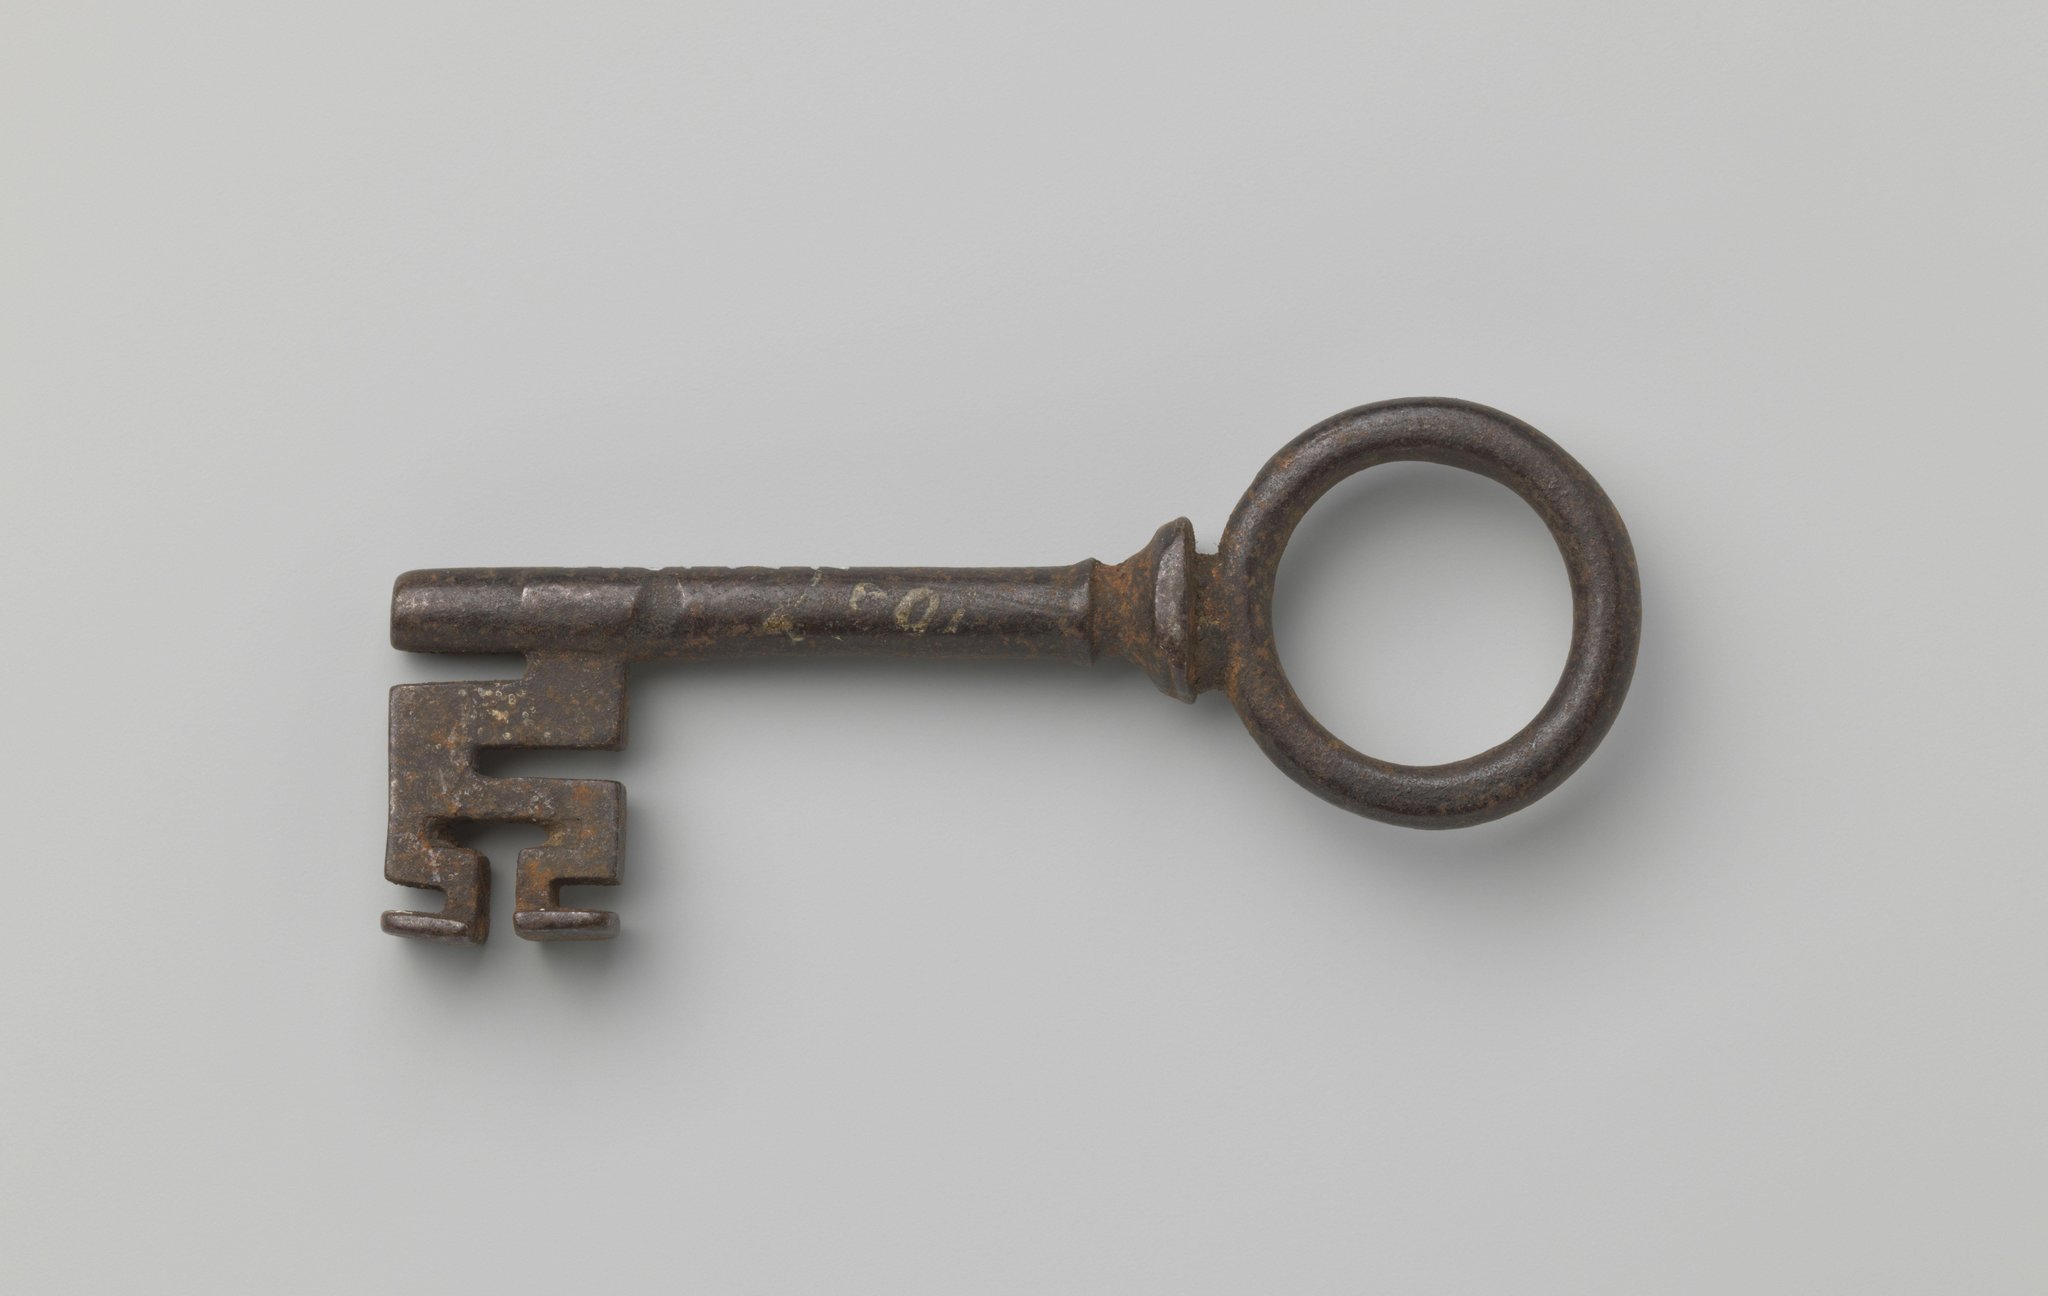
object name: key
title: Sleutel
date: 1400-1950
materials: iron